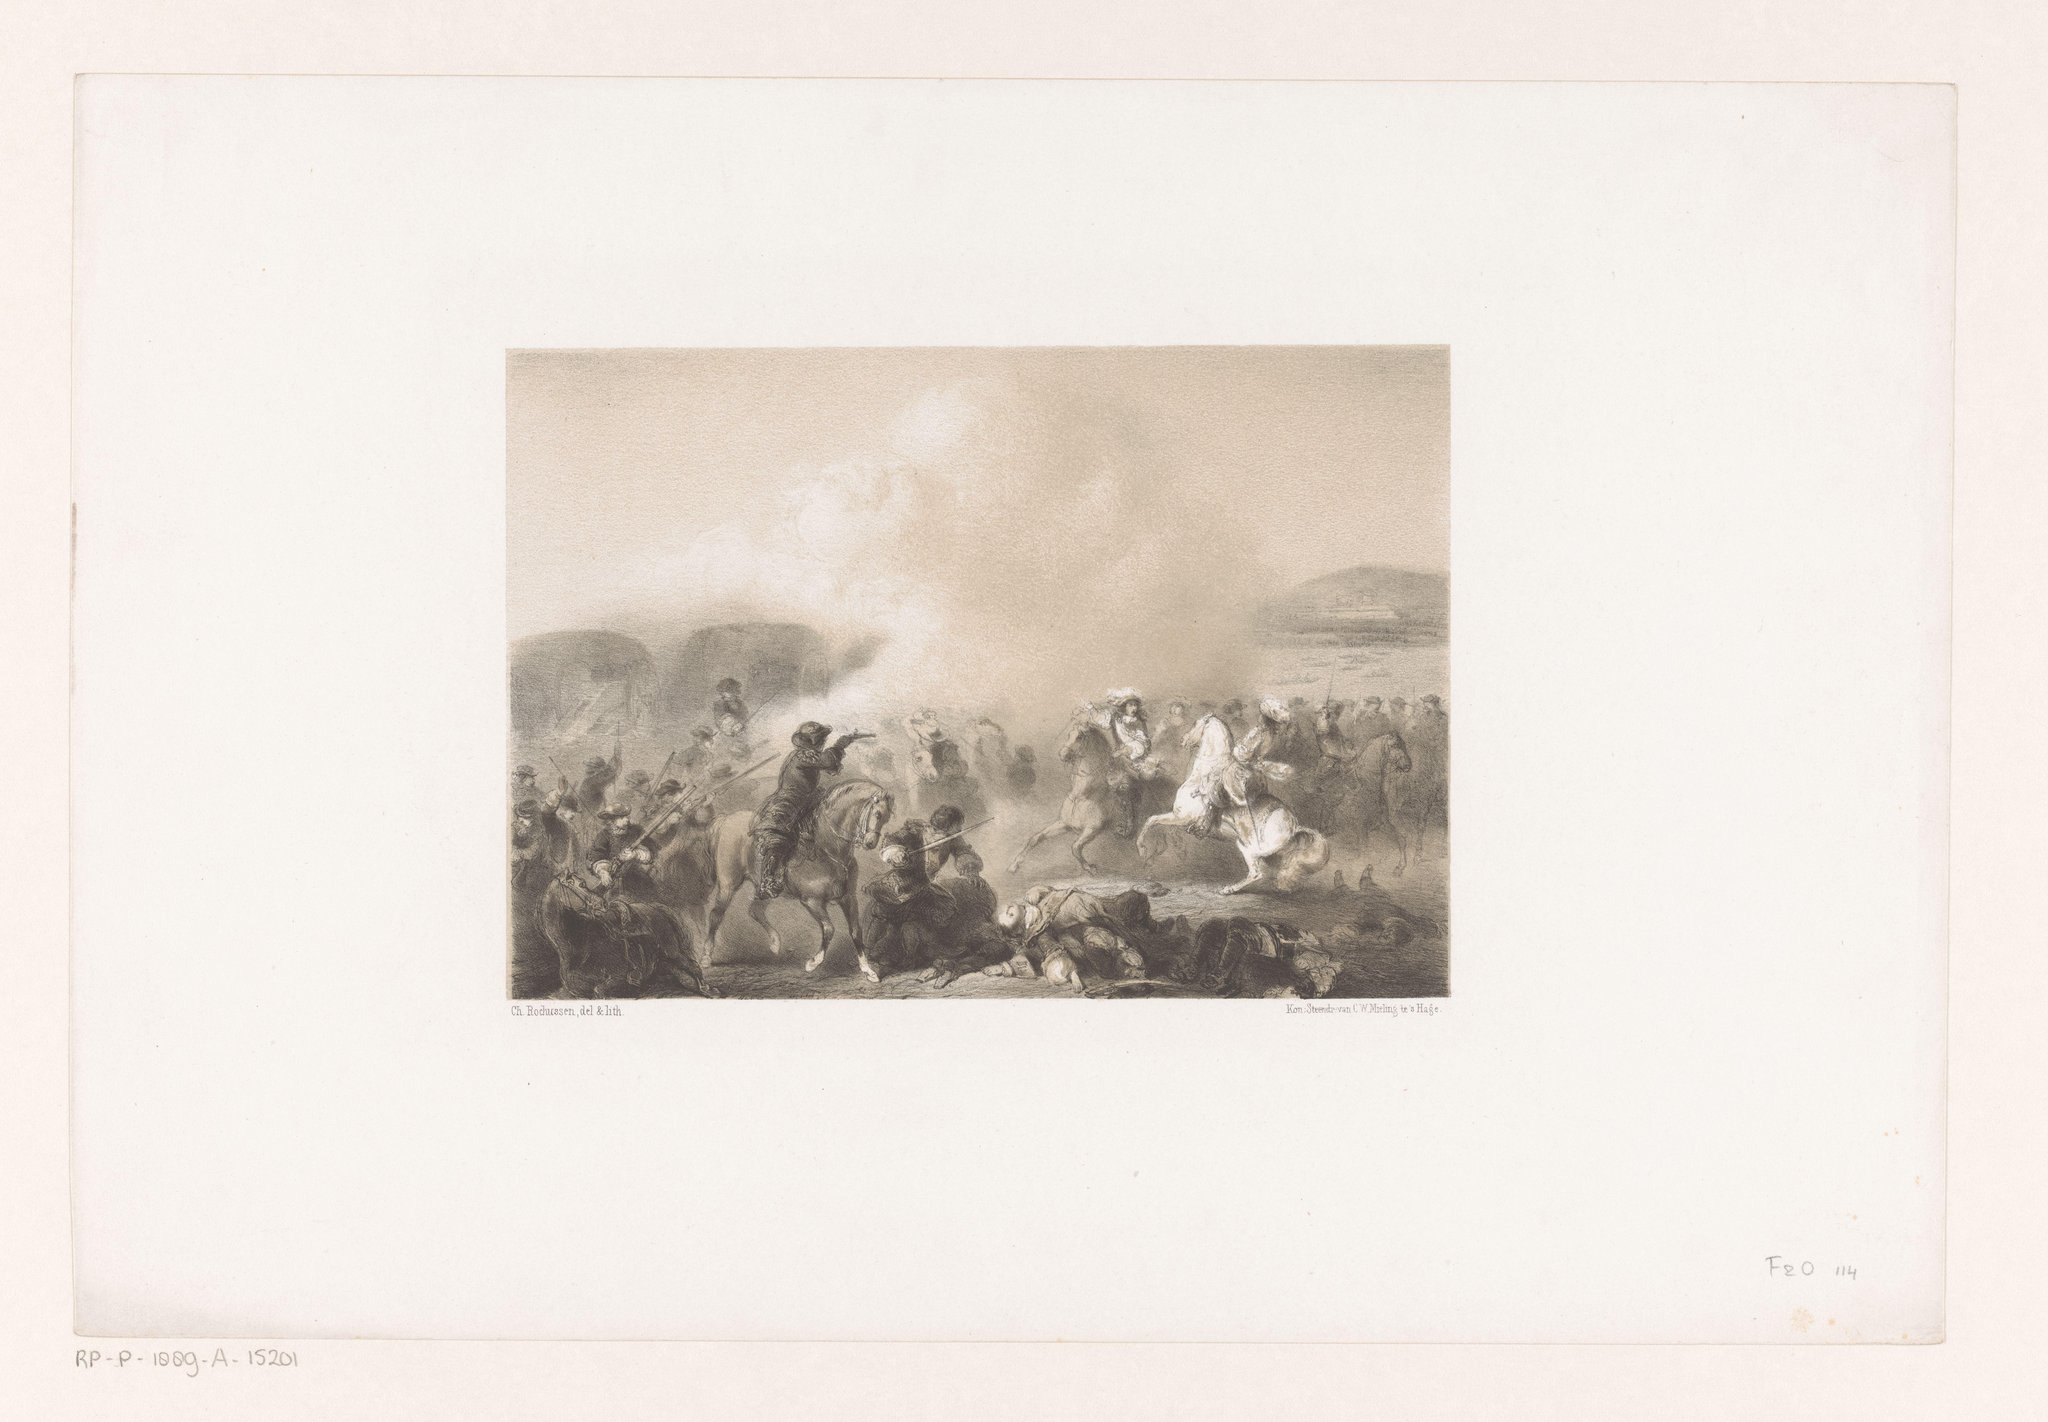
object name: print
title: Kapitein Ossenbroek verwondt Condé met pistoolschot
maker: charles rochussen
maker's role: draughtsman, painter, print maker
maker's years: 1814-1894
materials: paper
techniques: tone lithography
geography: the hague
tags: battle, firearms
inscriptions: collector's mark: Lugt 2228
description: Kapitein Ossenbroek verwondt Condé met een pistoolschot bij het oversteken van de Rijn in 1672. Links zit Ossenbroek met pistool te paard, omringd door soldaten. Rechts Condé en Franse ruiters. In de achtergrond de Rijn.